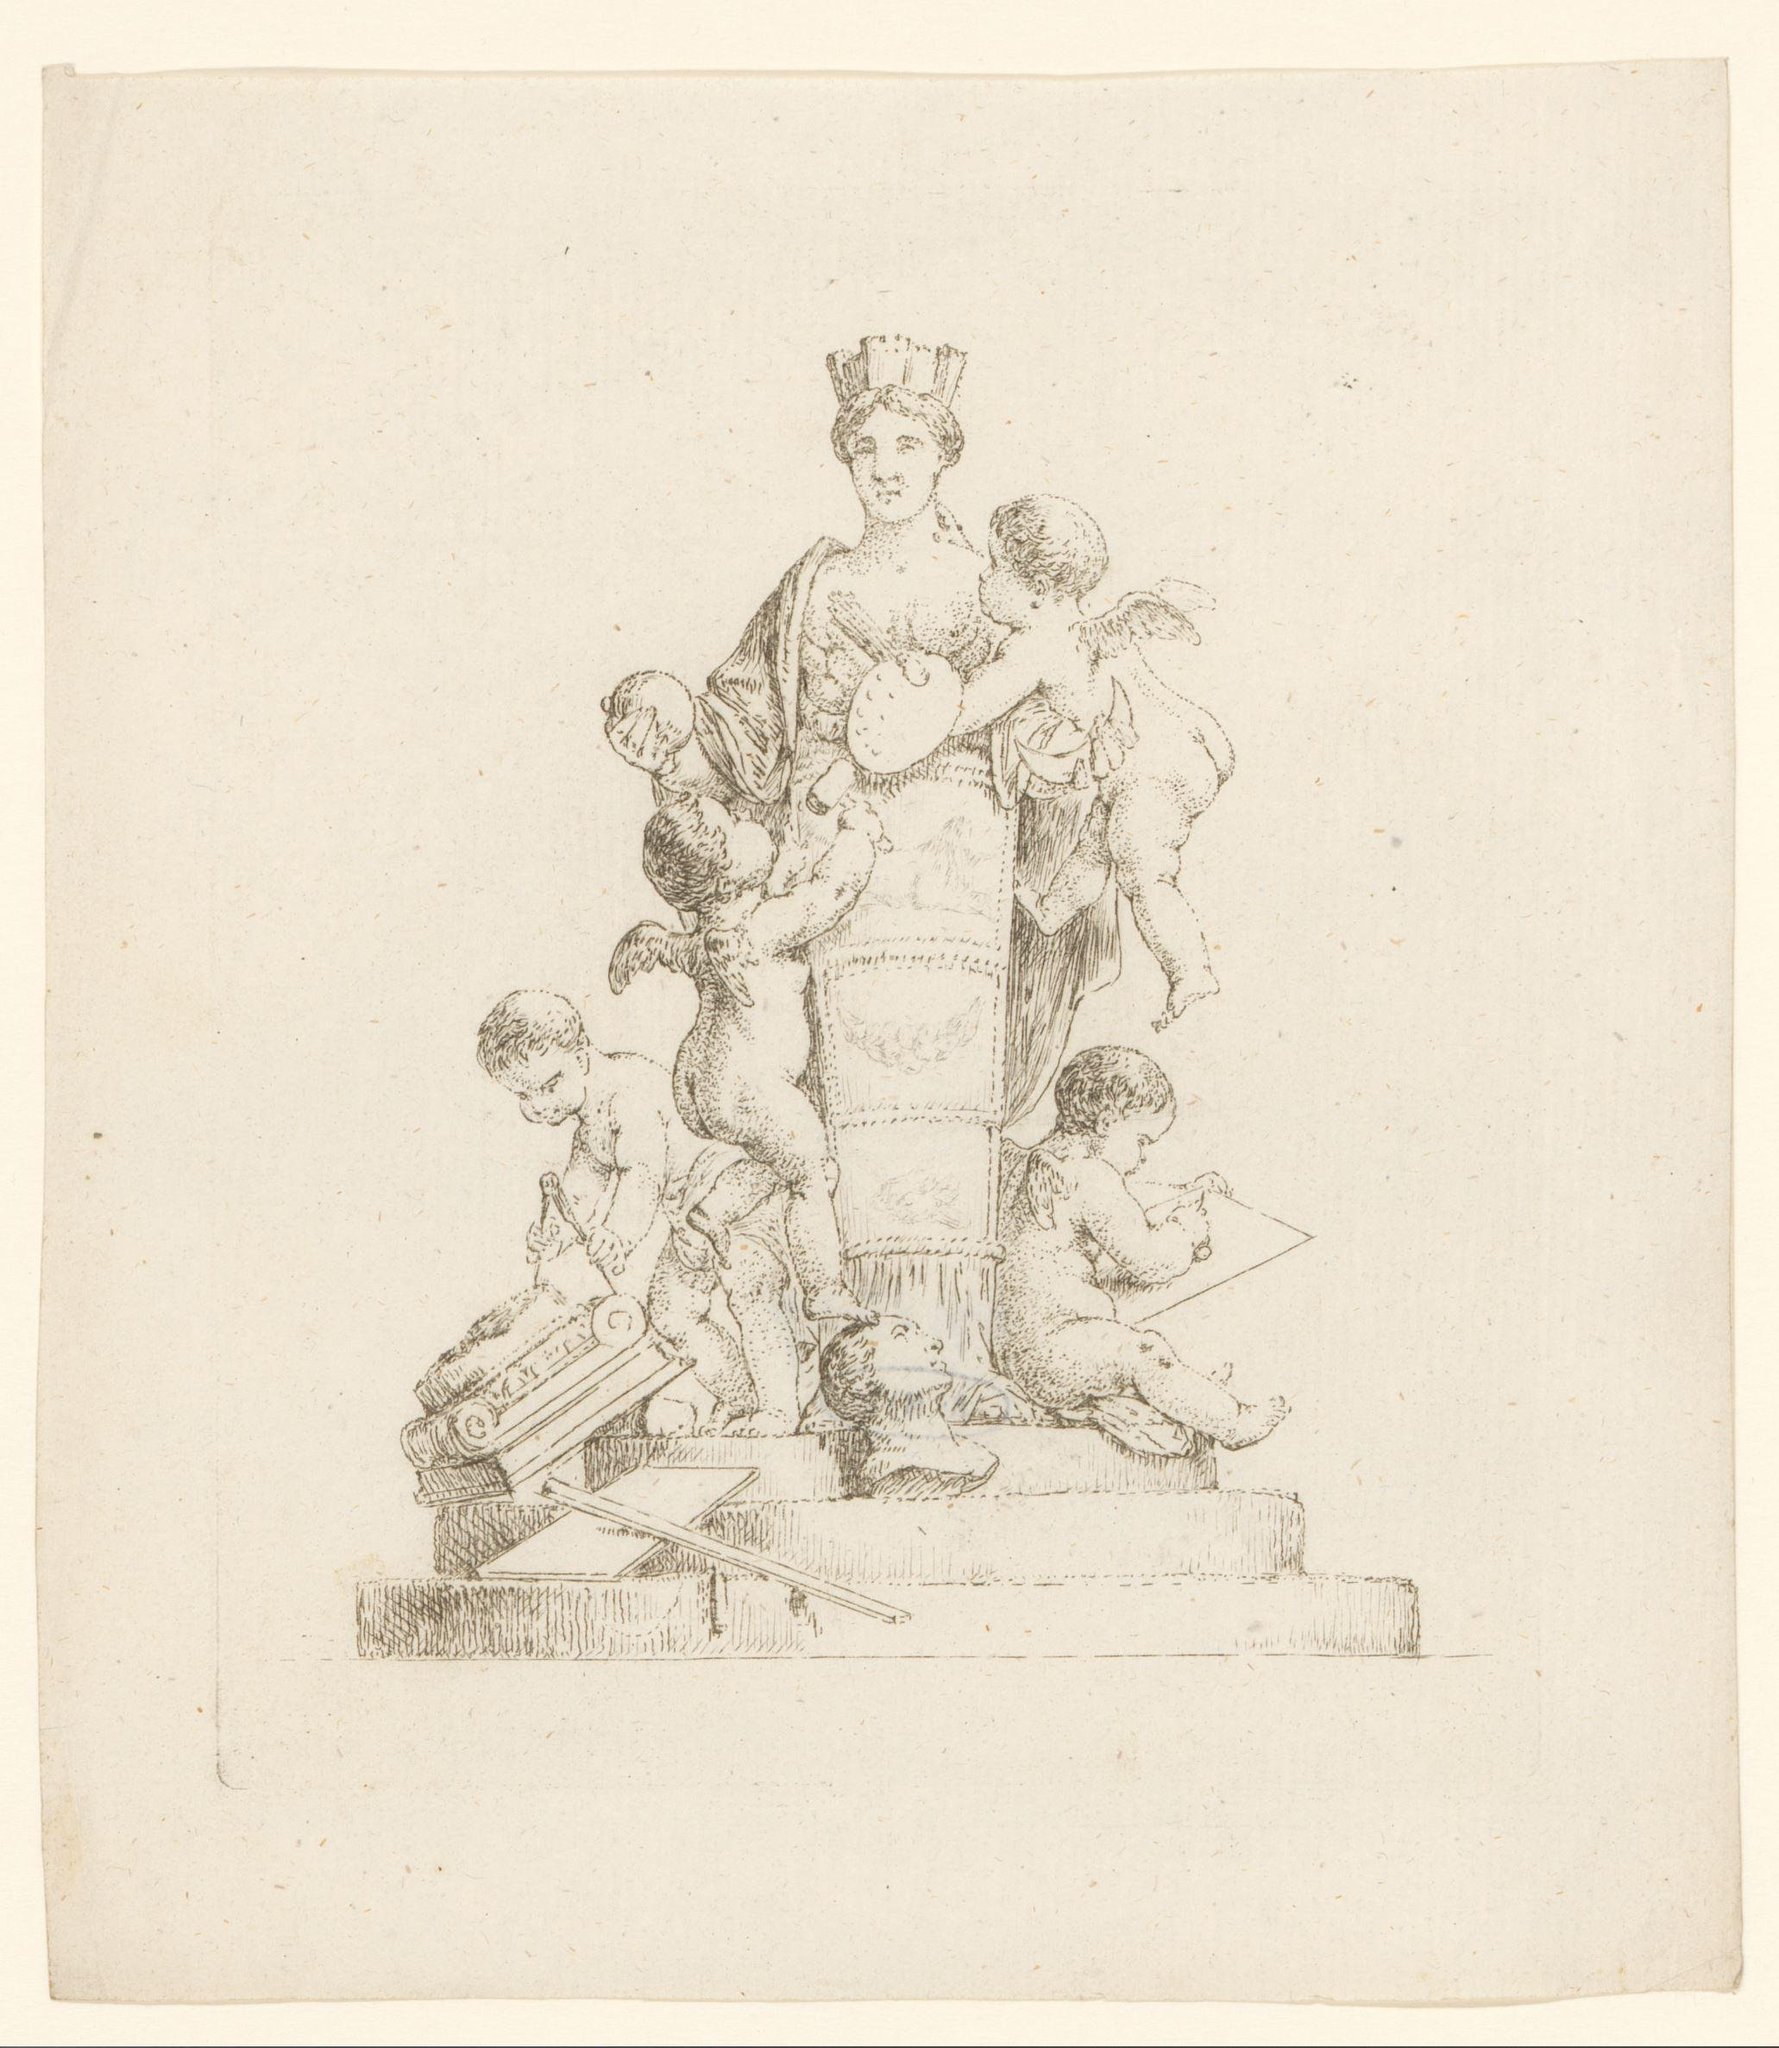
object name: print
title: Allegorie van de kunsten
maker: bernhard rode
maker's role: artist, print maker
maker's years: 1725-1797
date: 1788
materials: paper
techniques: etching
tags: the liberal arts, 'artes liberales'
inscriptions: collector's mark: Lugt 2228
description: Prent ook gebruikt in: Ramler, Karl Wilhelm. Allegorische Personen zum Gebrauche der bildenden Künstler. Berlijn: Akademischen Kunst- und Buchhandlung, 1788.